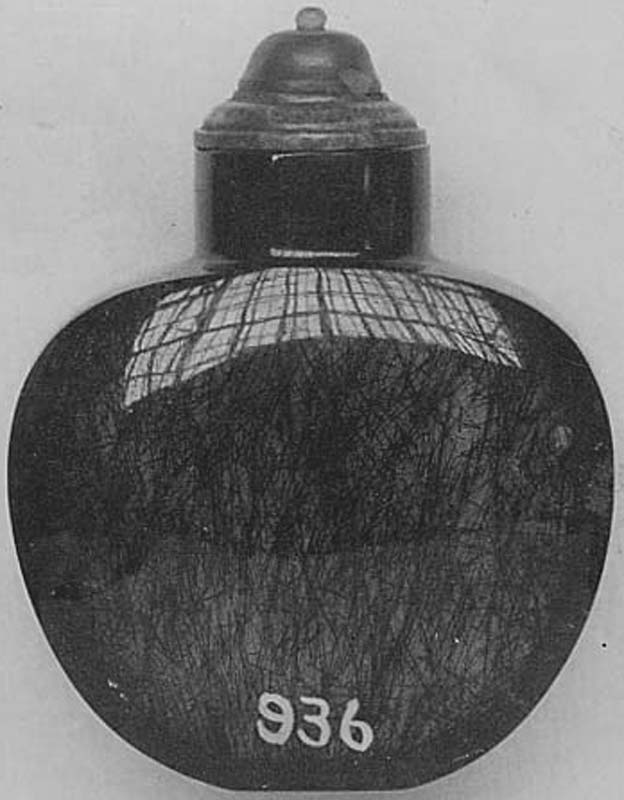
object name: snuff bottle with stopper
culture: chinese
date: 1701-1900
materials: stone, lapis lazuli, quartz